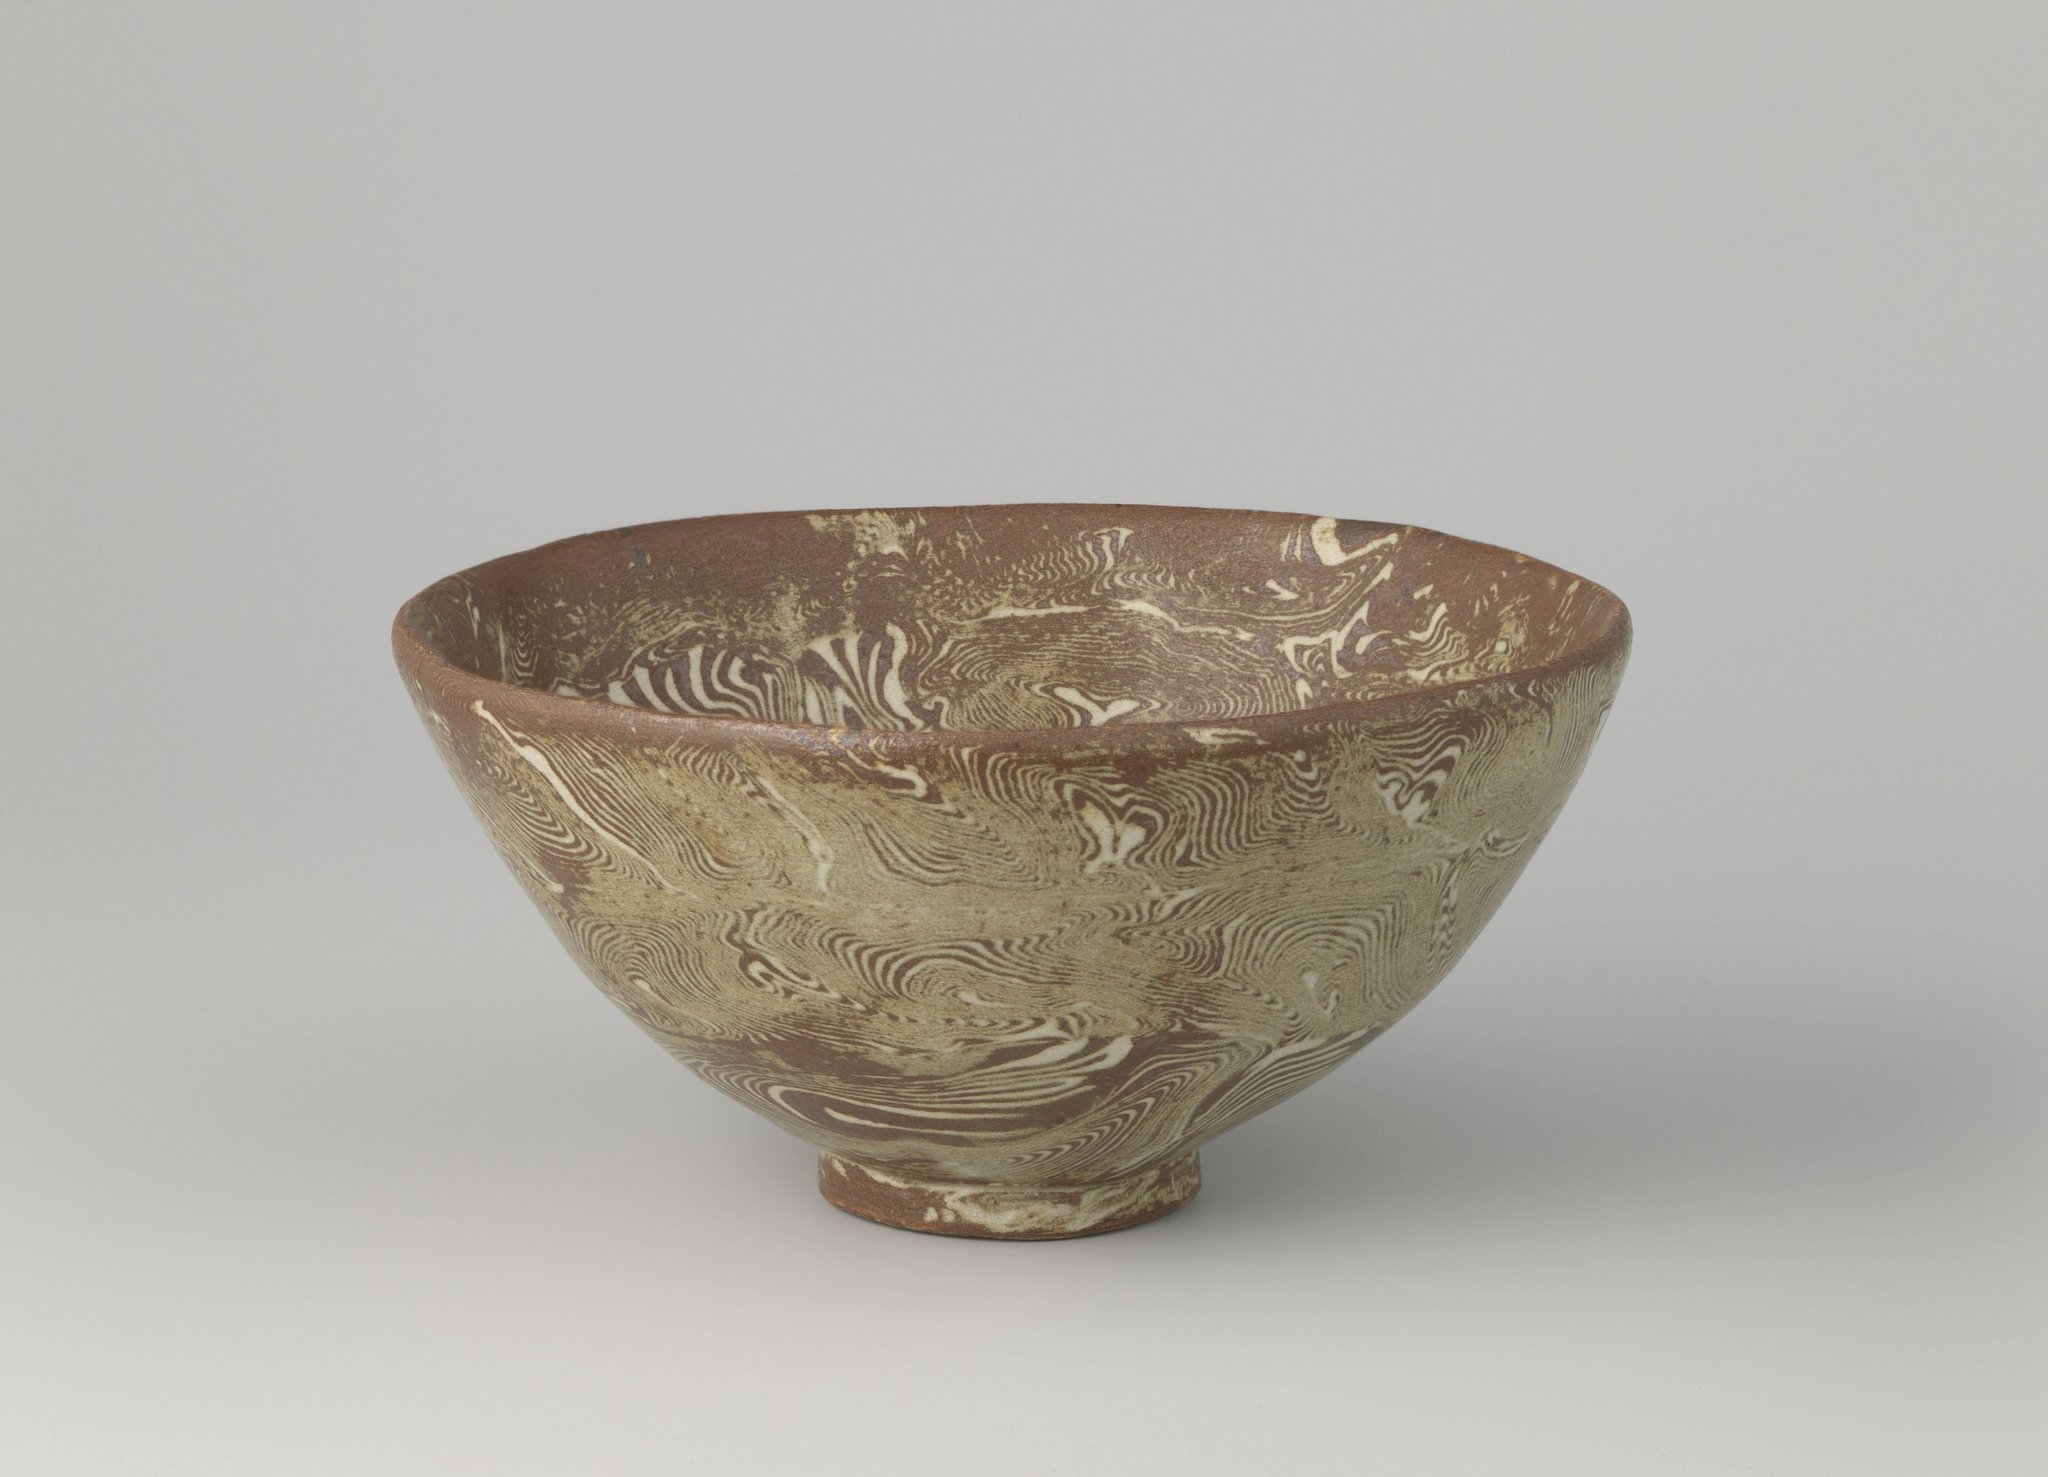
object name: bowl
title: Marbled bowl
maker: Anonymous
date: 960-1127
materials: stoneware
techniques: firing, turning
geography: china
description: Kom van gemarmerd steengoed in bruin en crème. Cizhou[?].